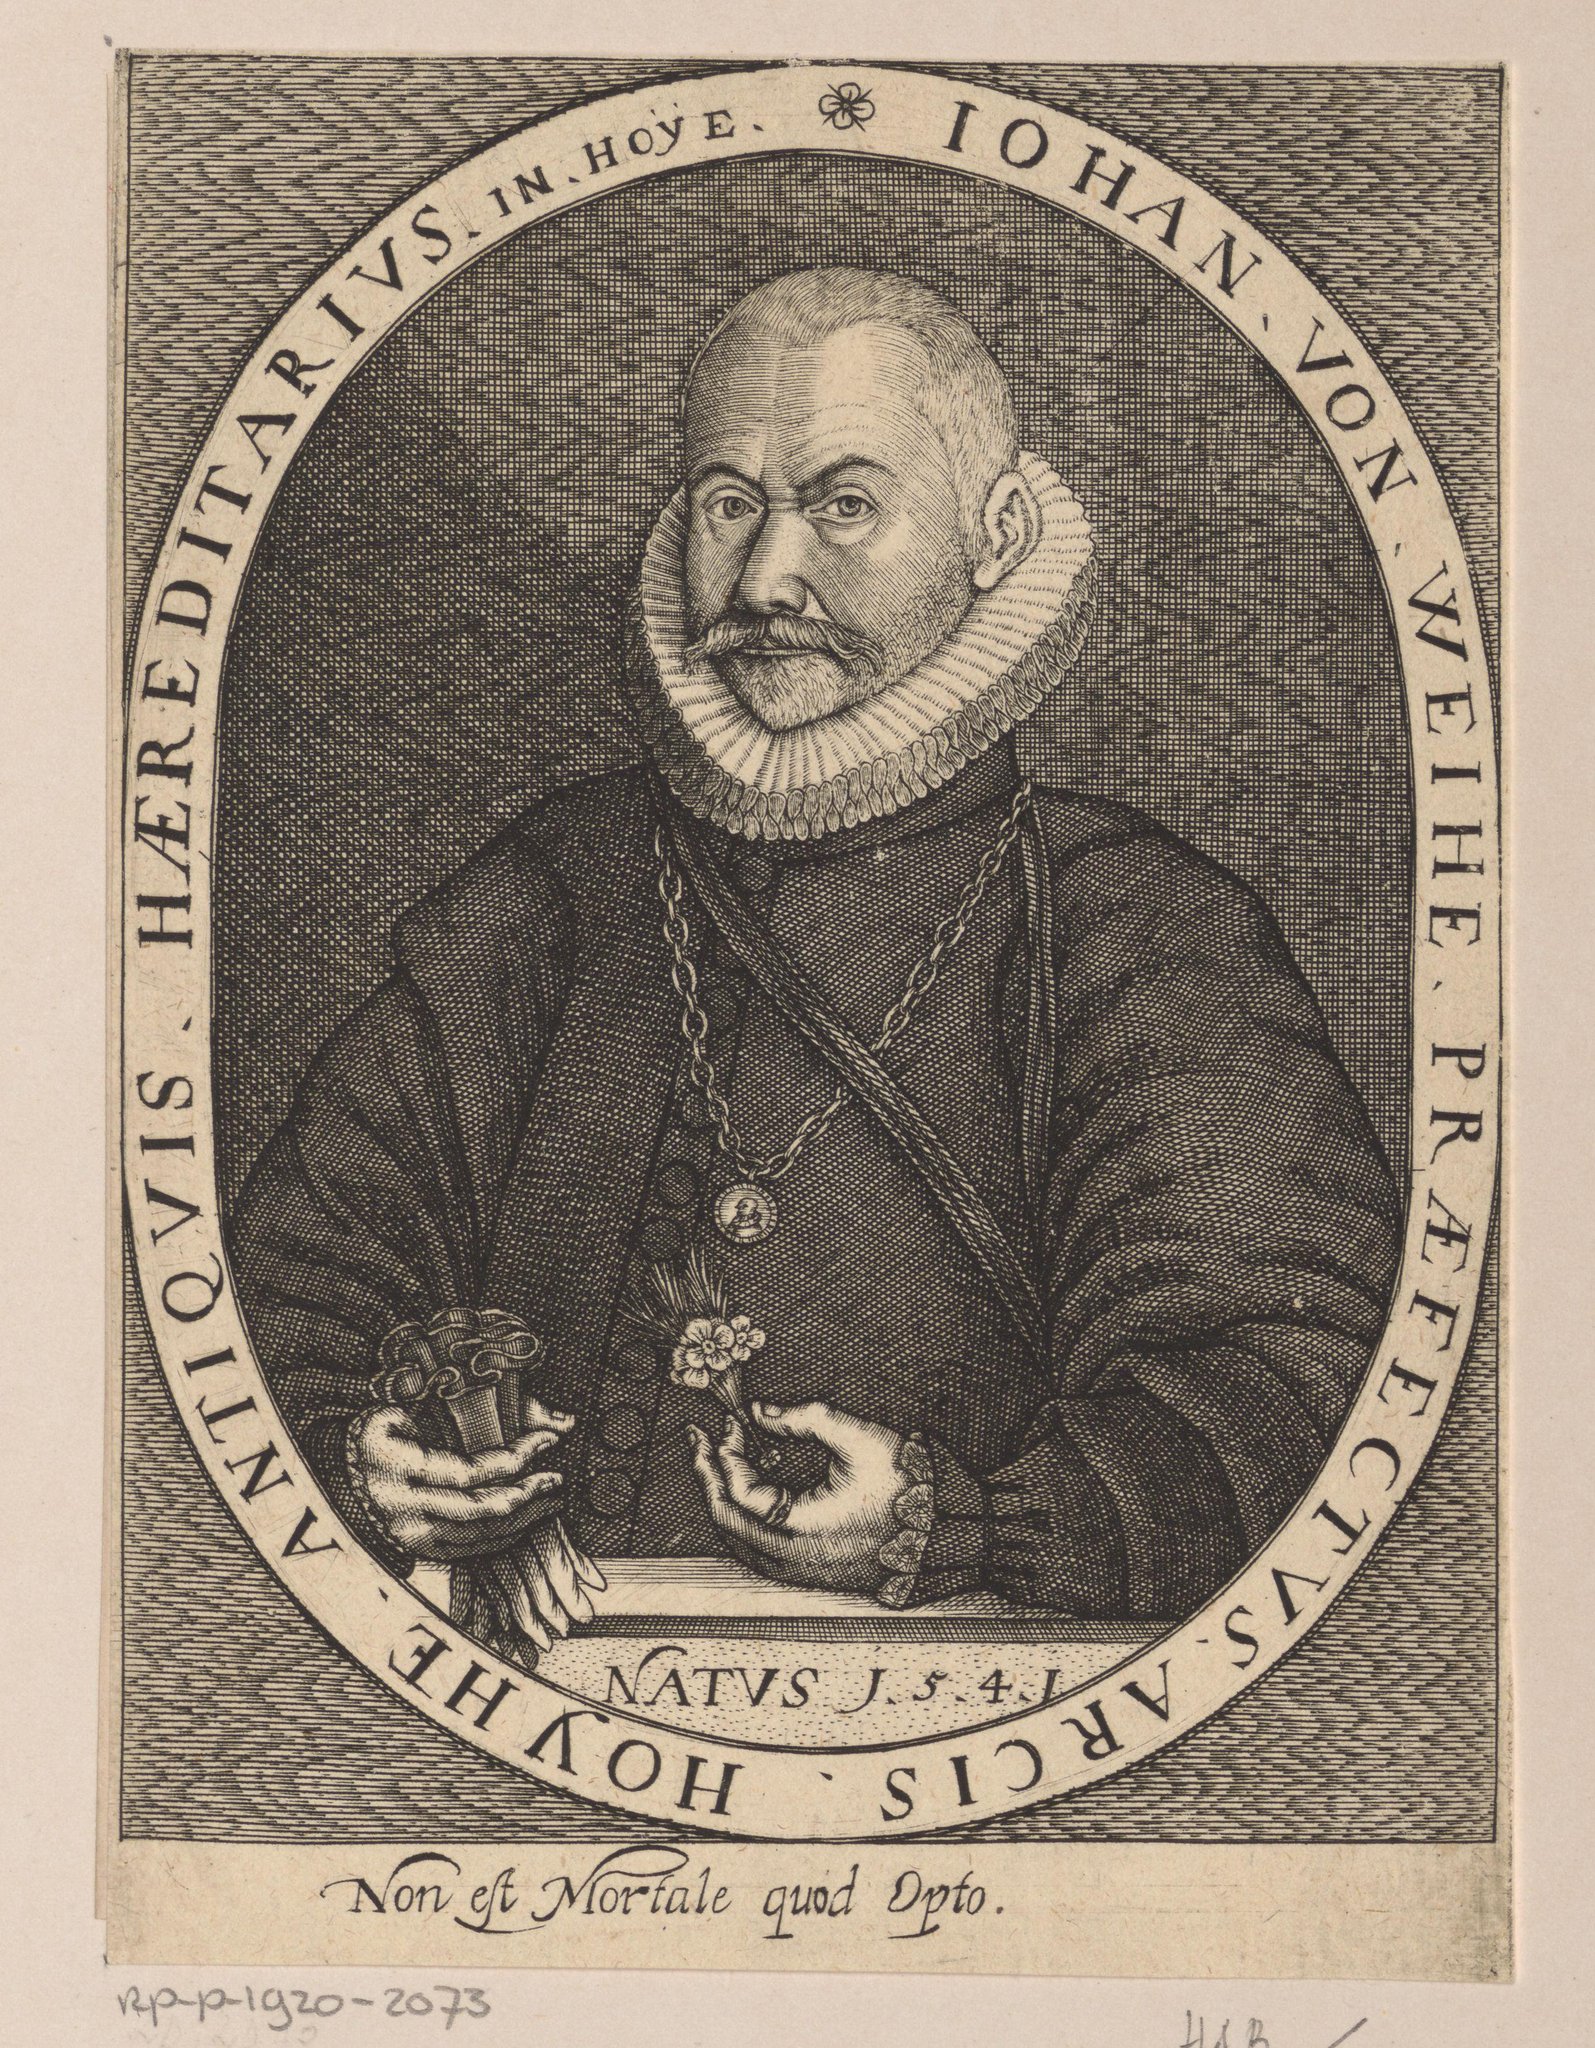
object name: print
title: Portret van Johann von Weyhe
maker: Anonymous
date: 1600-1699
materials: paper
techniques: engraving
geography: germany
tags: cut flowers; nosegay, bunch of flowers, gloves, mittens, etc., historical persons, pendant, trinket, 'breloque'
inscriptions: collector's mark: Lugt 2228